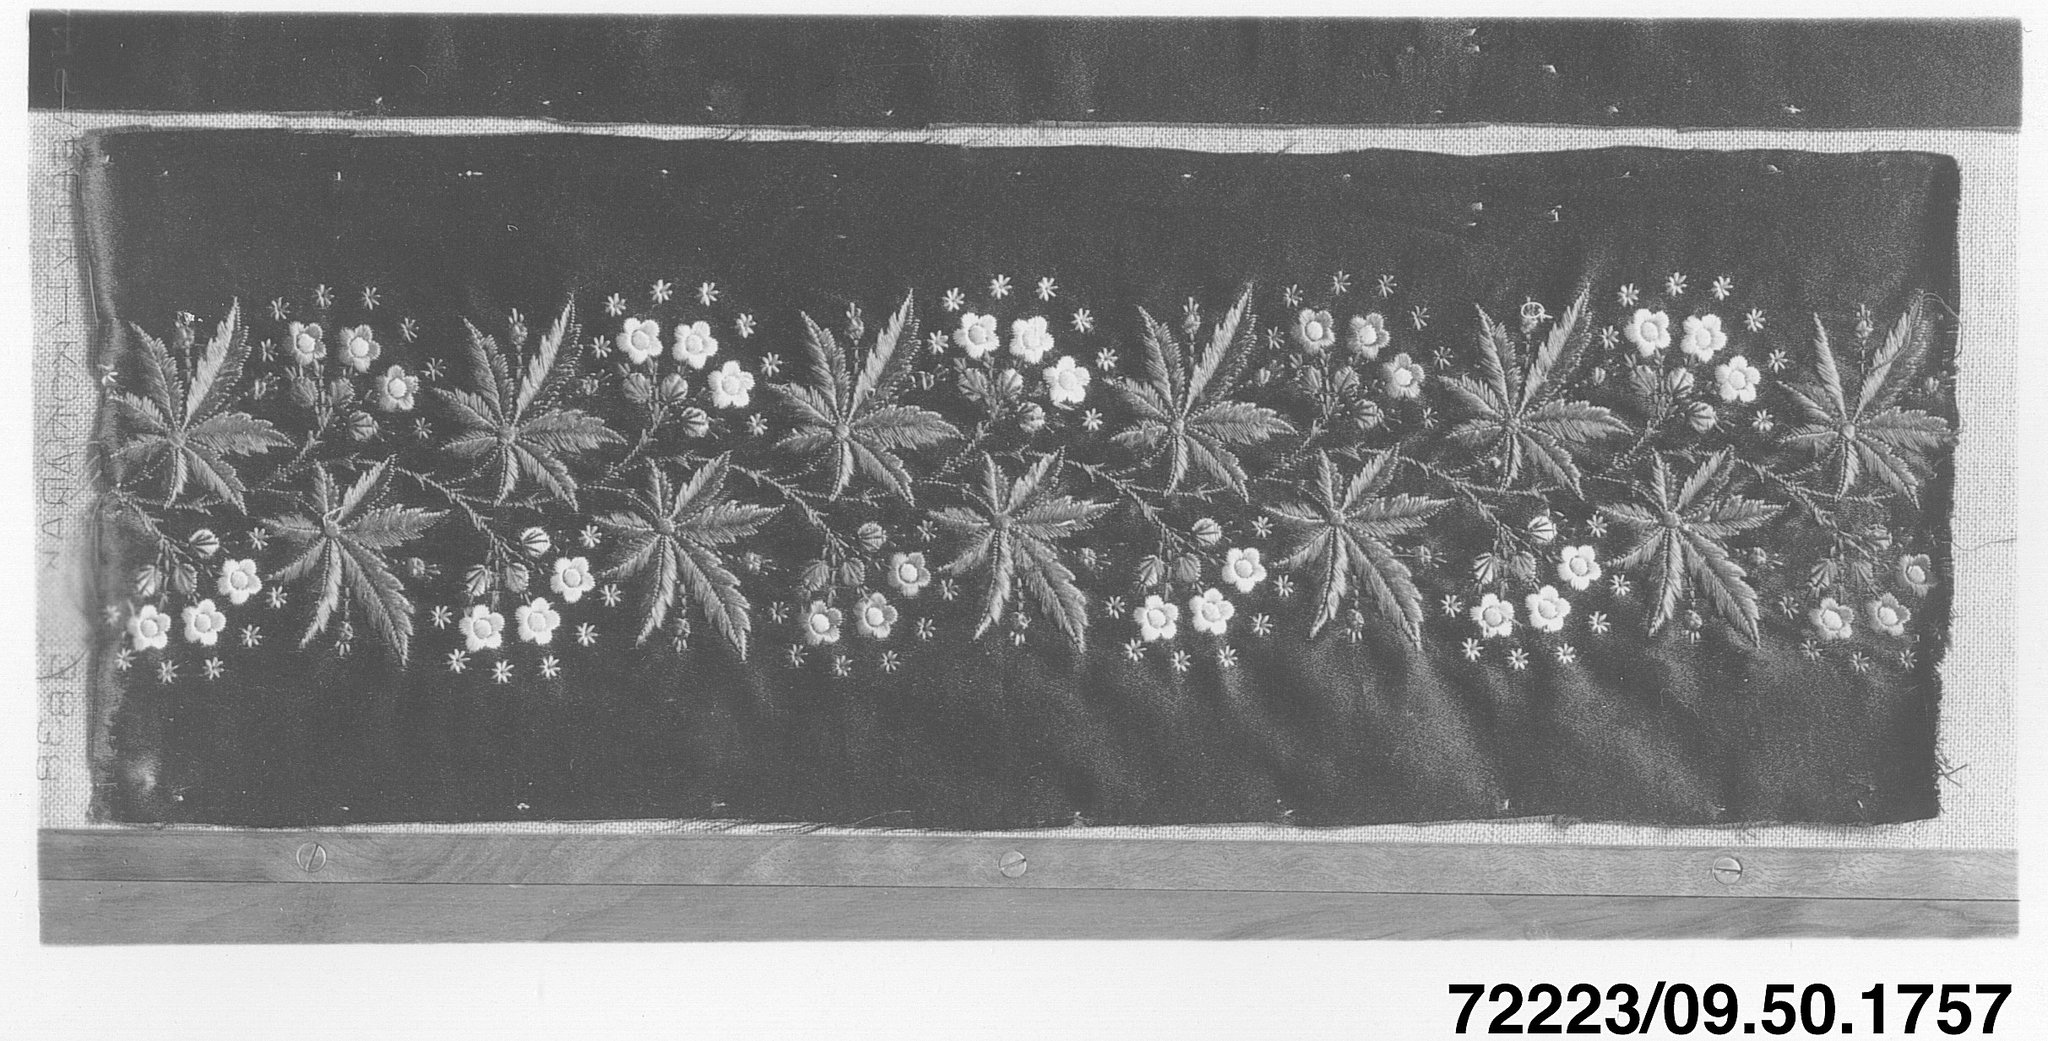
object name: fragment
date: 1801-1900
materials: silk